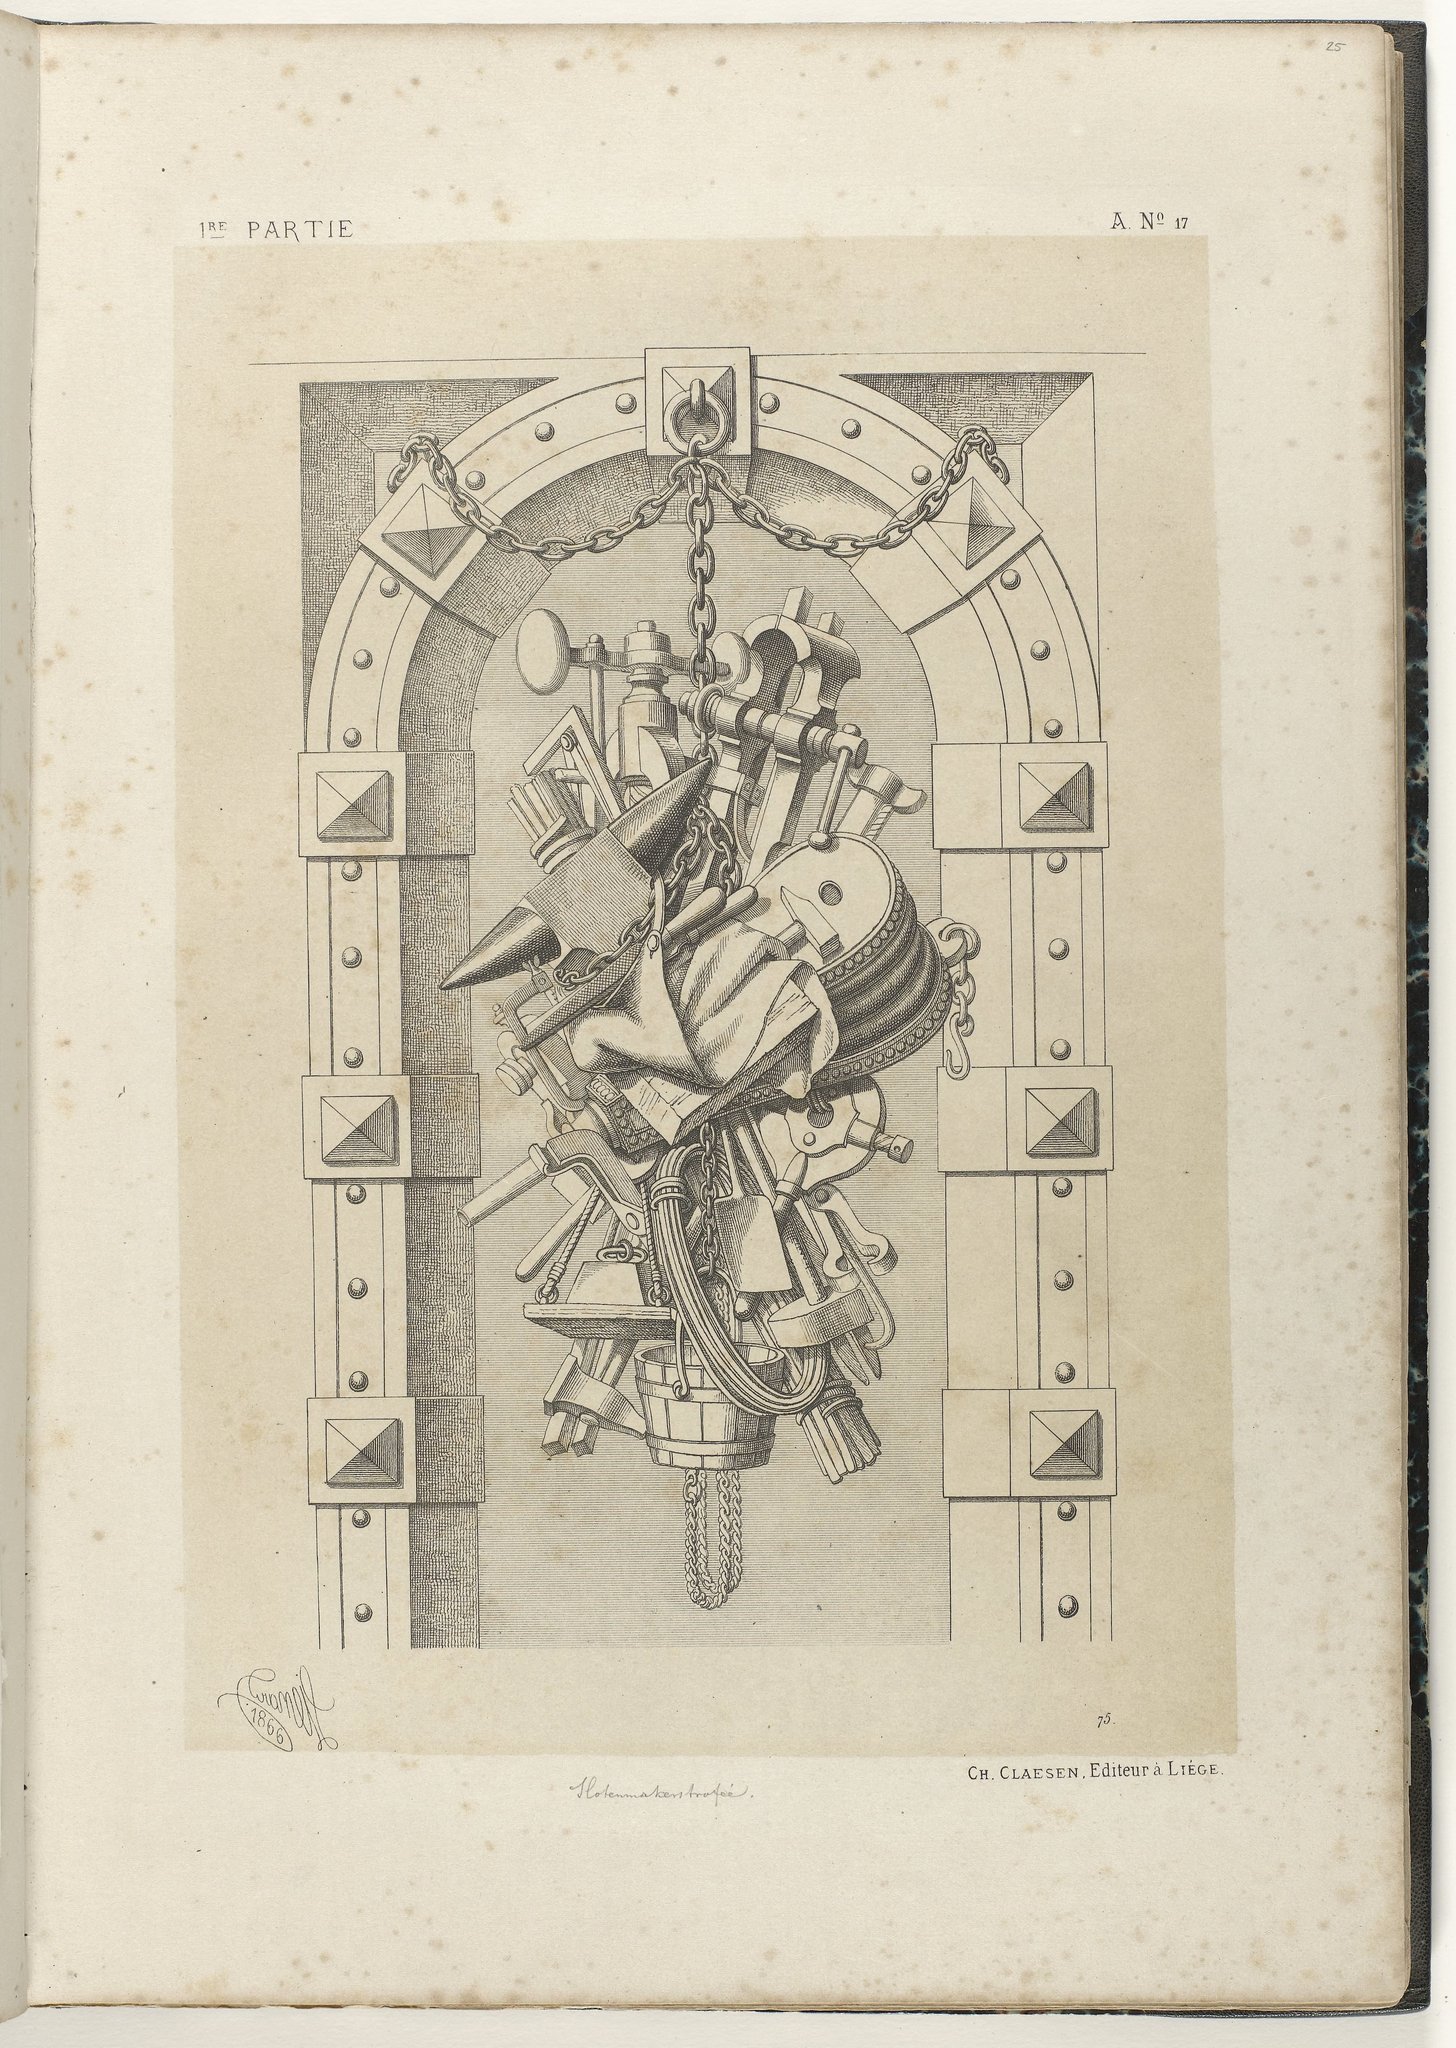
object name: print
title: Trofee van smidsgereedschap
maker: michel liénard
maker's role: print maker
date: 1866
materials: paper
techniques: tone lithography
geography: liège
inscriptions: annotation: ‘Slotenmakerstrofeé.’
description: Trofee hangend aan een ketting onder een boog. Linksboven: 1re partie, rechtsboven: A. N° 17, rechtsonder: 75.